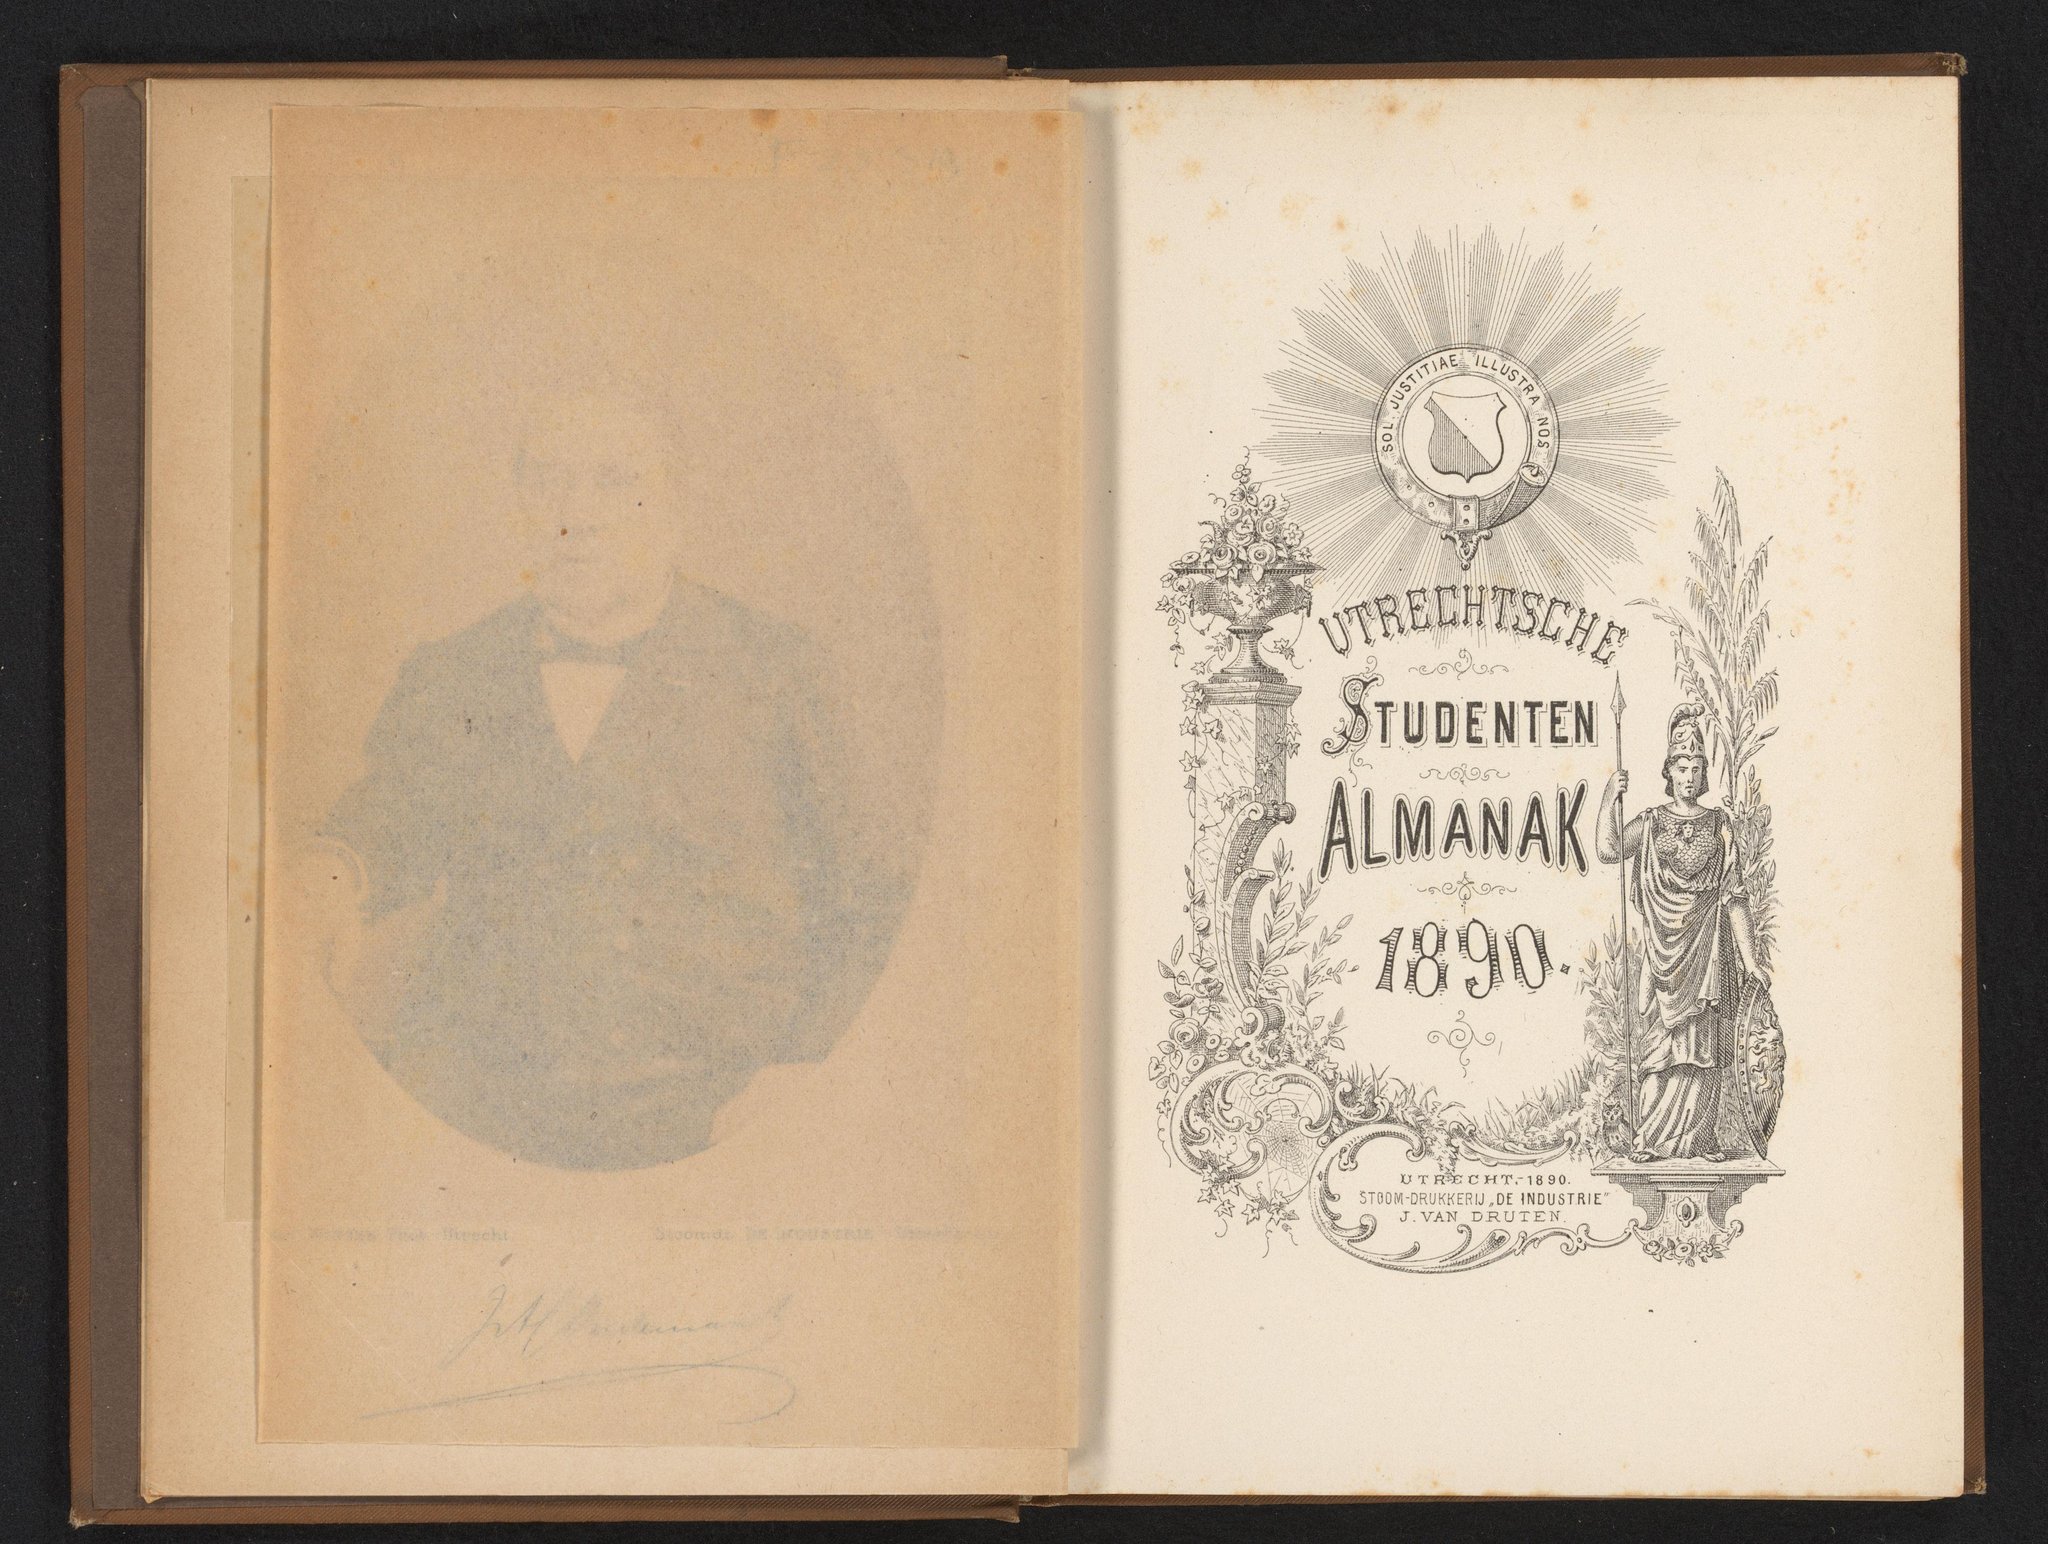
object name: book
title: Utrechtsche studenten-almanak voor het jaar 1890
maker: j. van druten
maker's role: publisher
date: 1890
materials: cardboard, linen, paper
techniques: albumen print, letterpress printing, lithograph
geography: utrecht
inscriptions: number: ‘450’